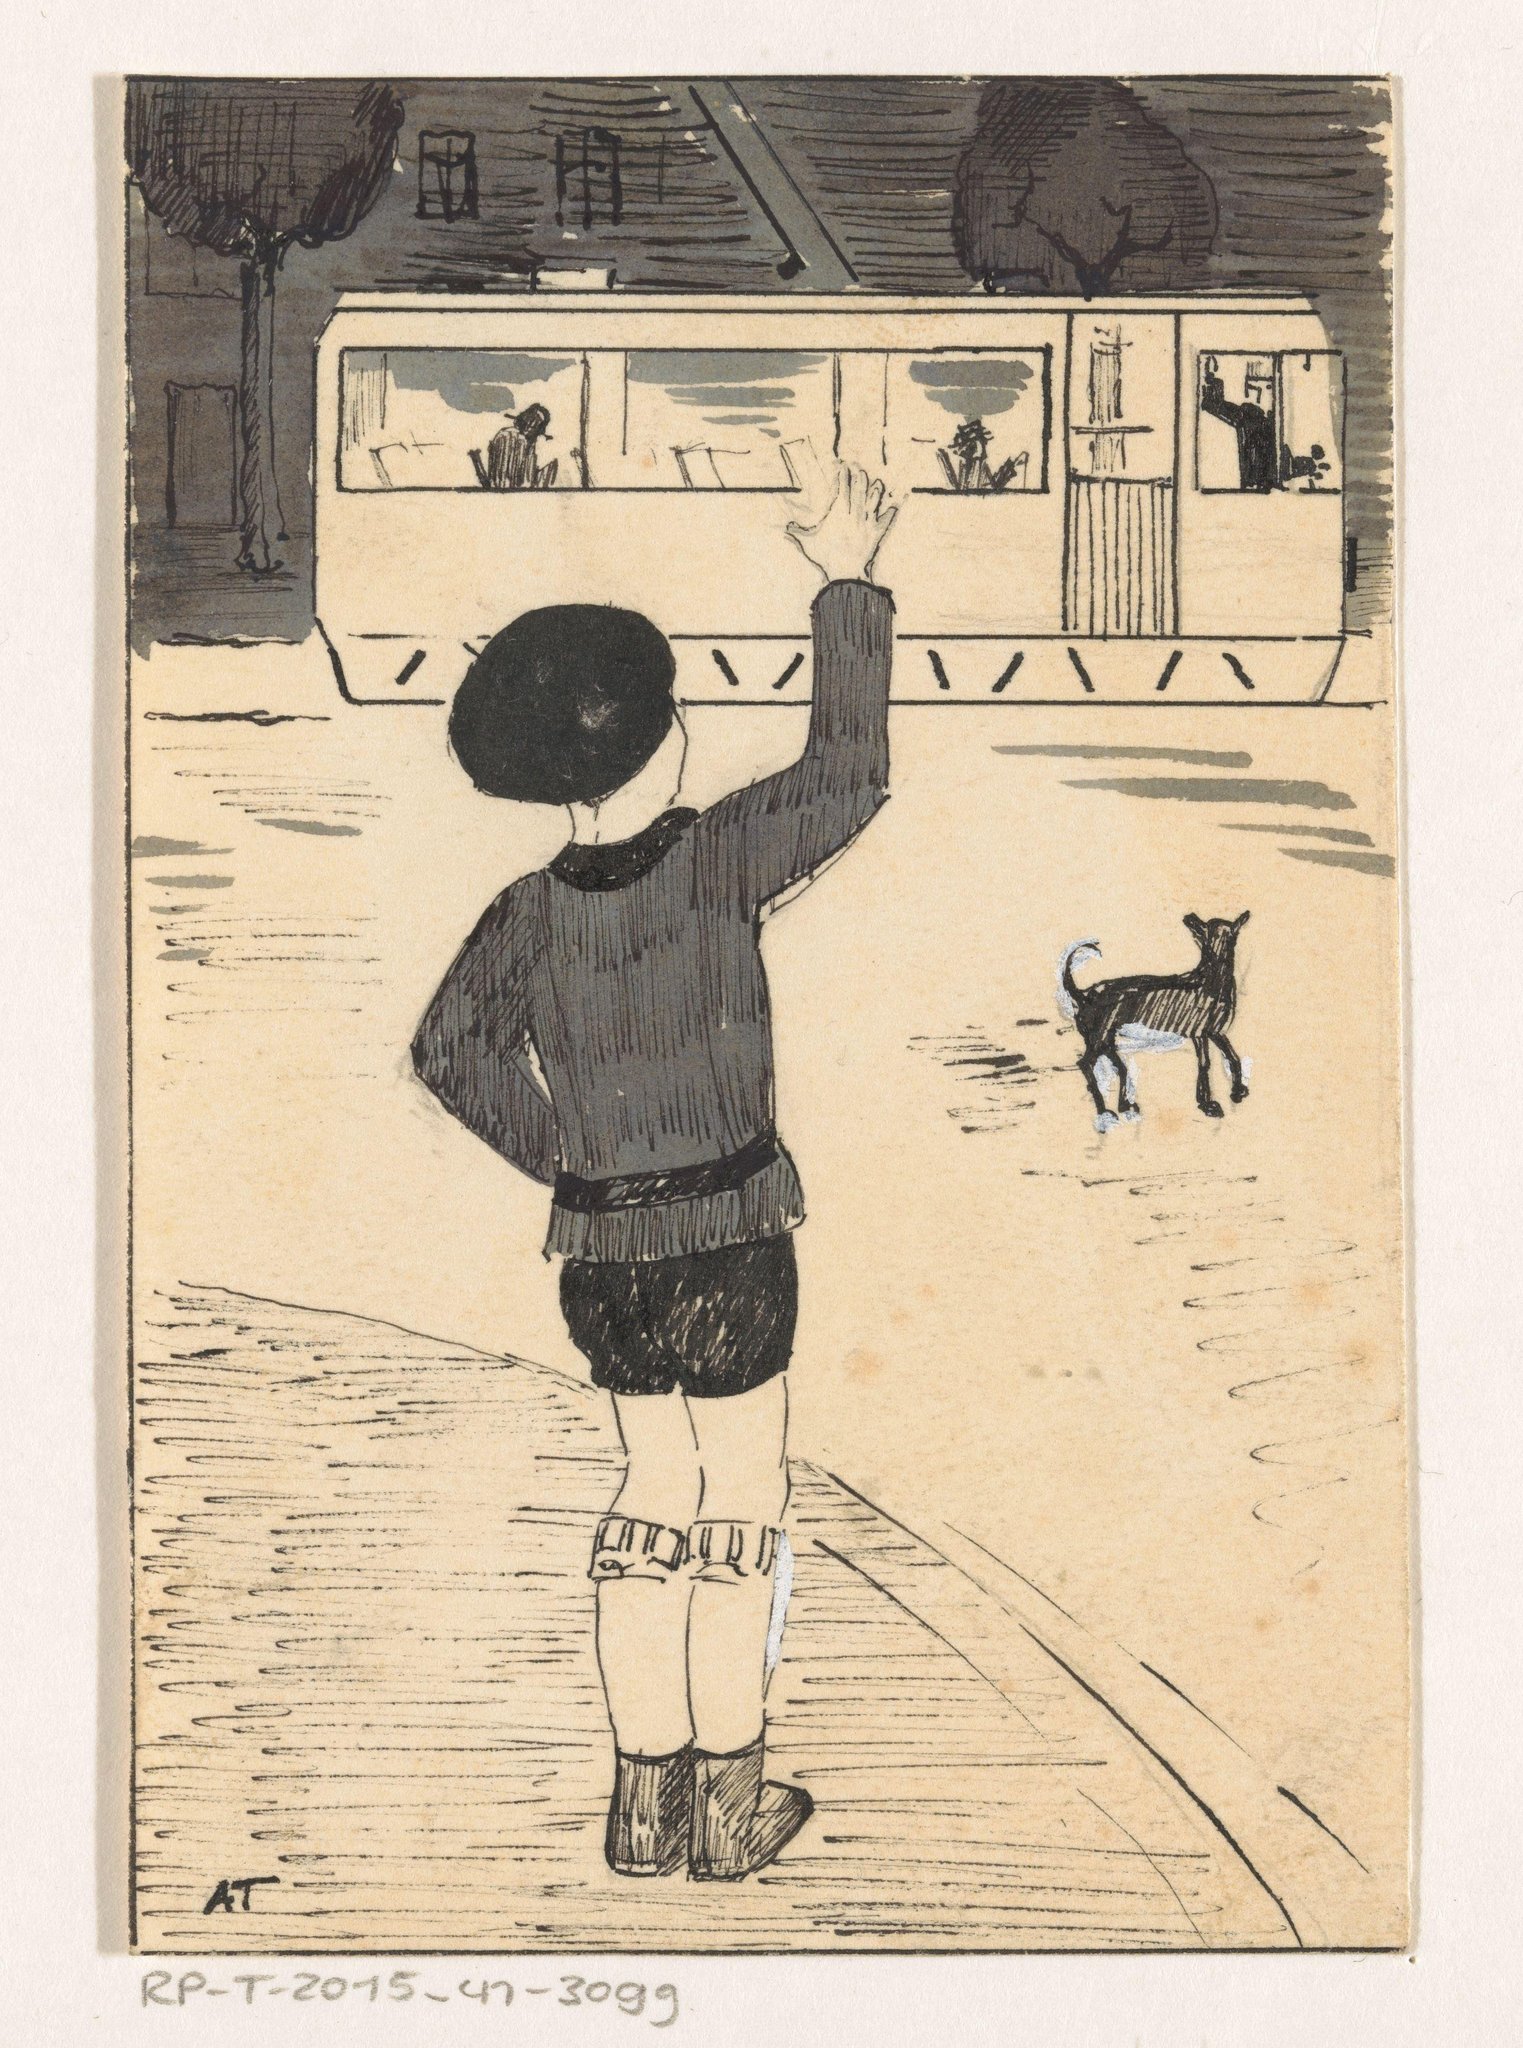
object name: drawing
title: Jongen zwaait naar een bestuurder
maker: a. tinbergen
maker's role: draughtsman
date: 1925-1935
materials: paint, ink, paper, pencil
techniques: brush, pen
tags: waving farewell ~ departure on a journey, dog, street (+ city(-scape) with figures, staffage)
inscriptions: collector's mark: Lugt 2228a, :, monogram: ‘AT’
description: Een jongen staat op een stoep en zwaait naar de bestuurder van een voertuig in de verte. Op de straat staat een hond.